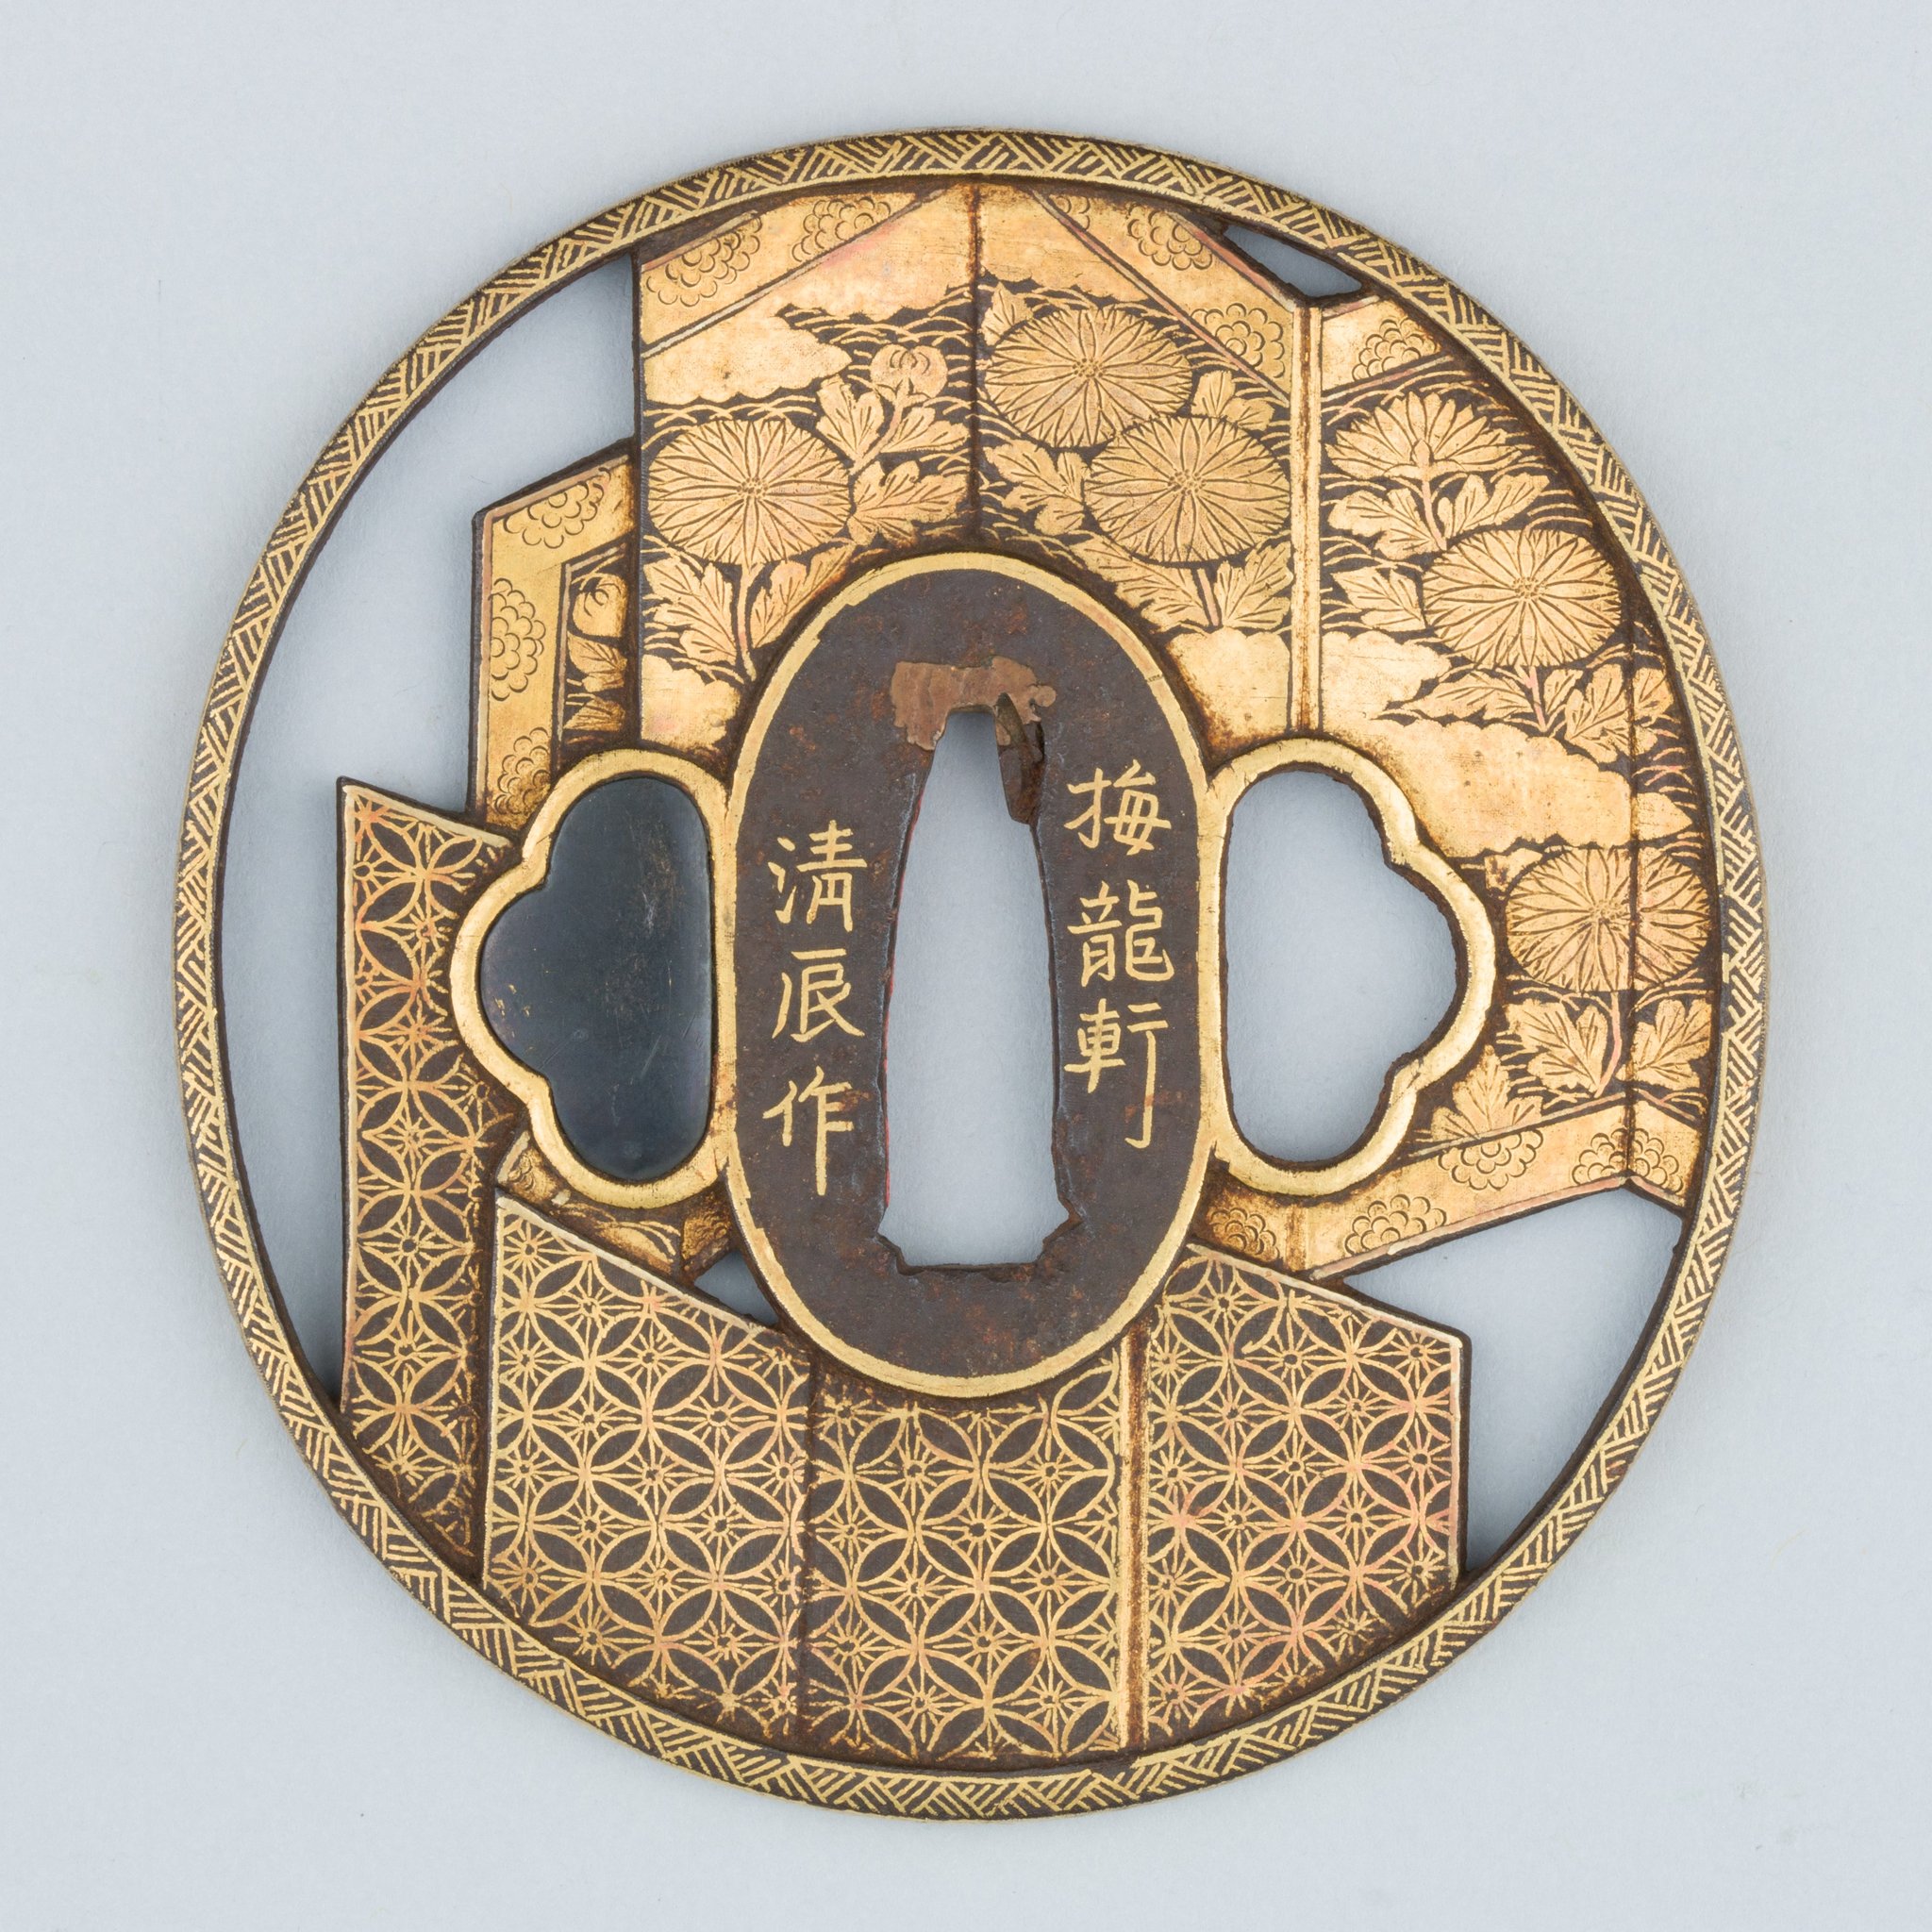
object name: sword guard tsuba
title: Sword Guard (Tsuba)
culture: japanese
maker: bairyūken kiyotatsu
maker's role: fittings maker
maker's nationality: japanese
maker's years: 1750-1800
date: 1767-1800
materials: gold alloy, gold, iron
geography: japan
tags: flowers,screens